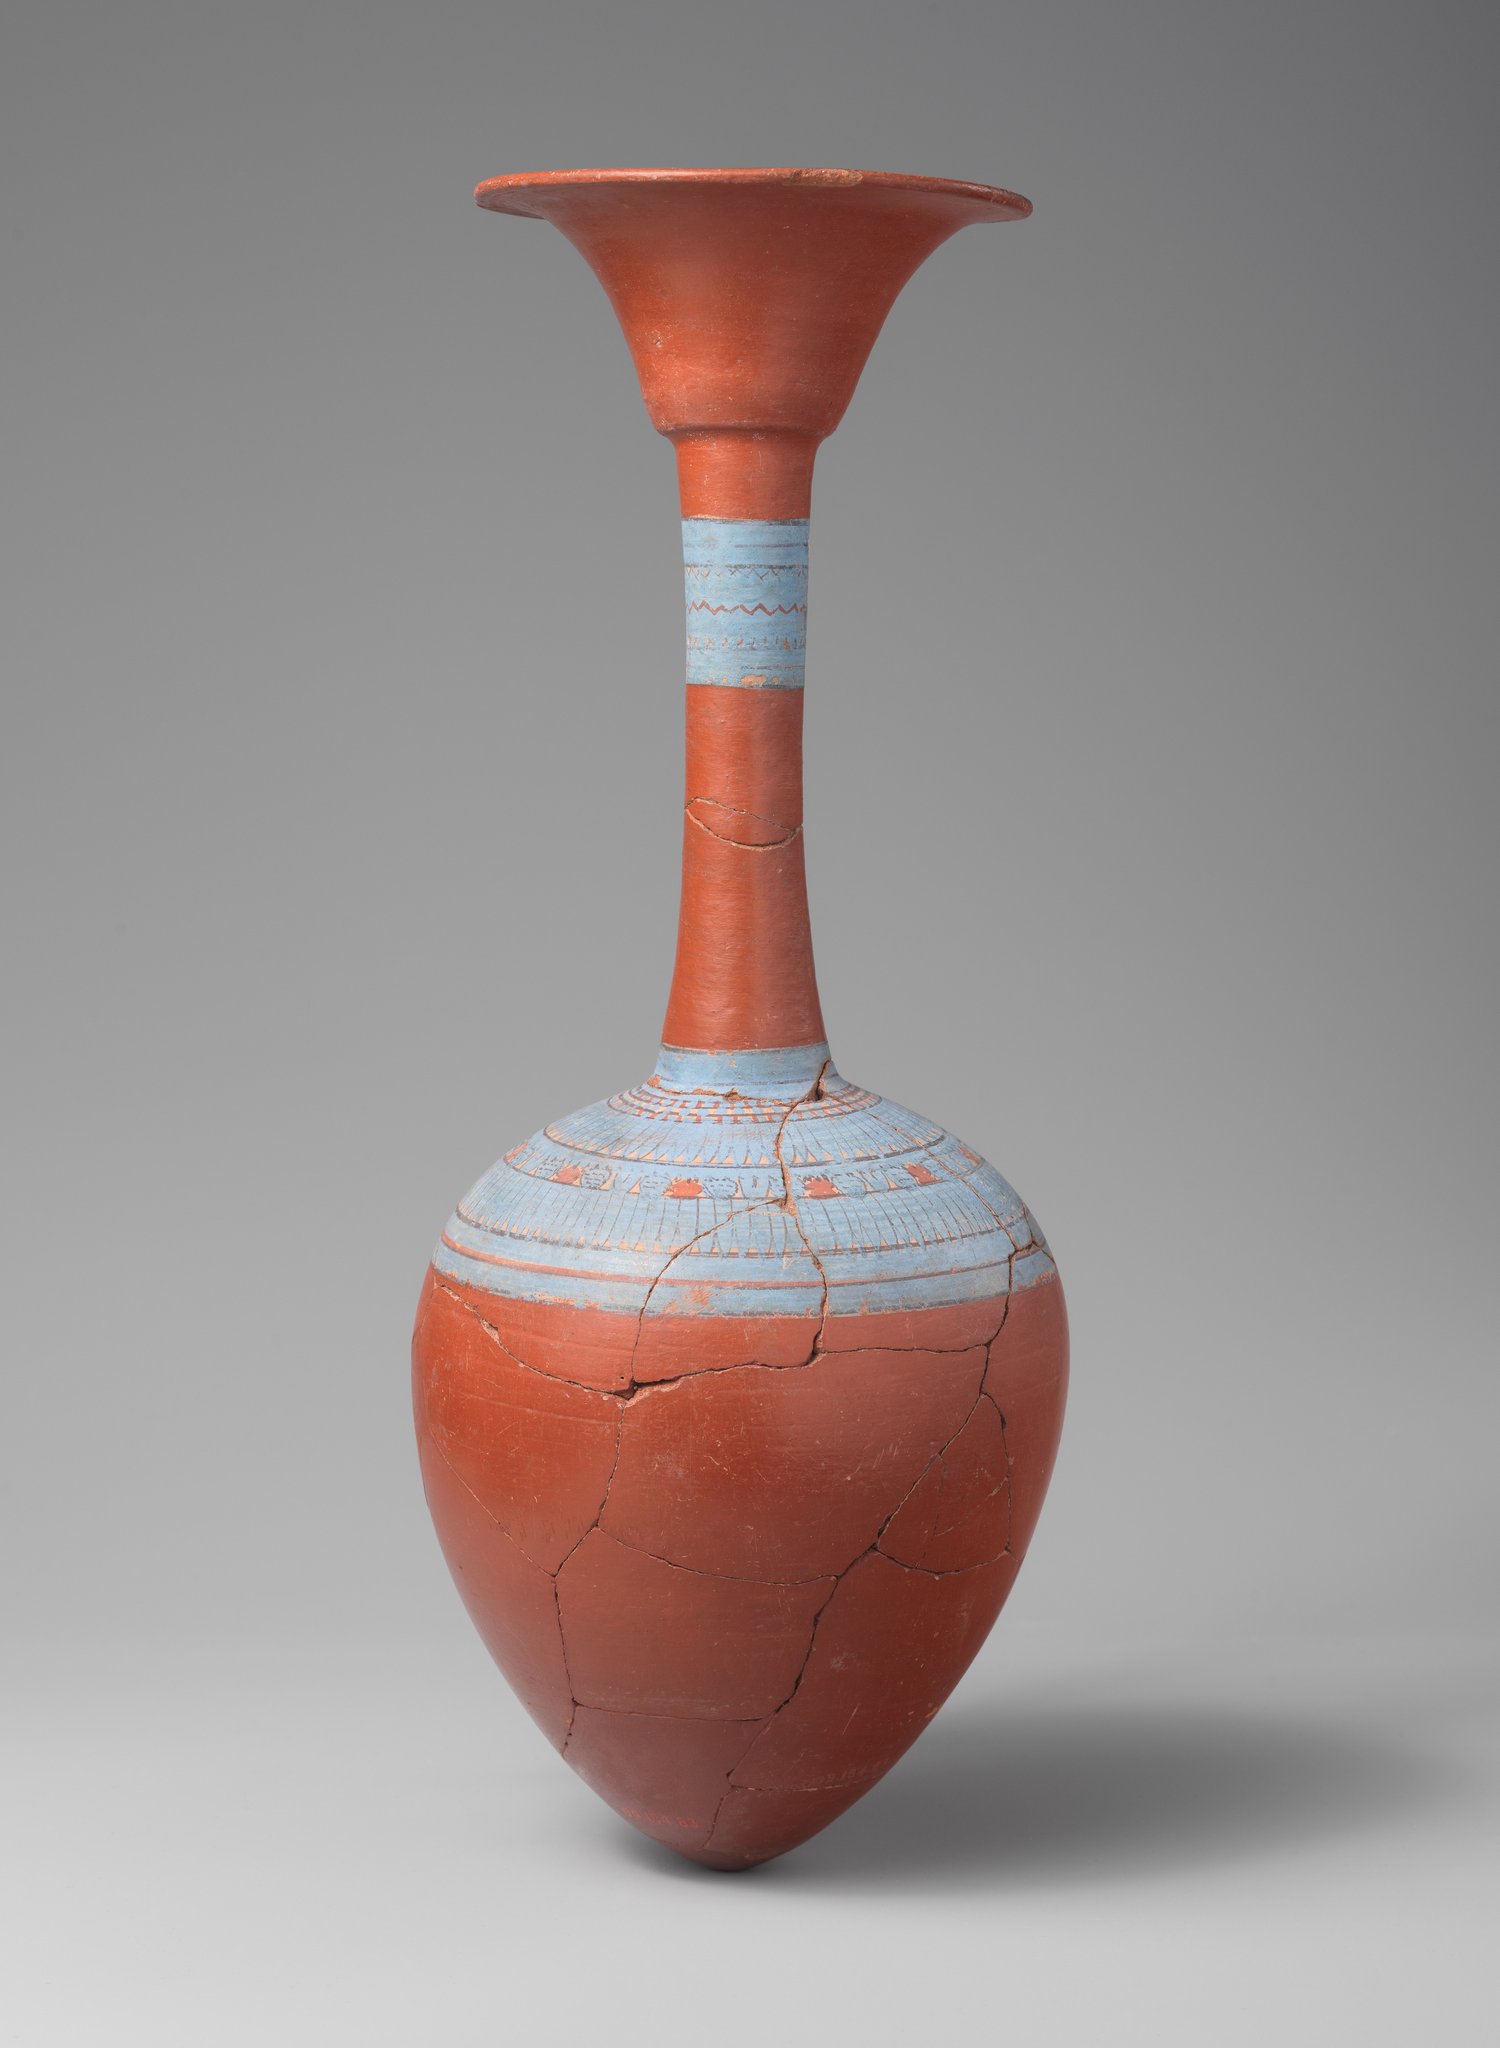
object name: bottle, long necked, wine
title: Water Bottle from Tutankhamun's Embalming Cache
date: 1336-1327 BCE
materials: mineral, pigment, pottery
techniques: burnishing, wash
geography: egypt